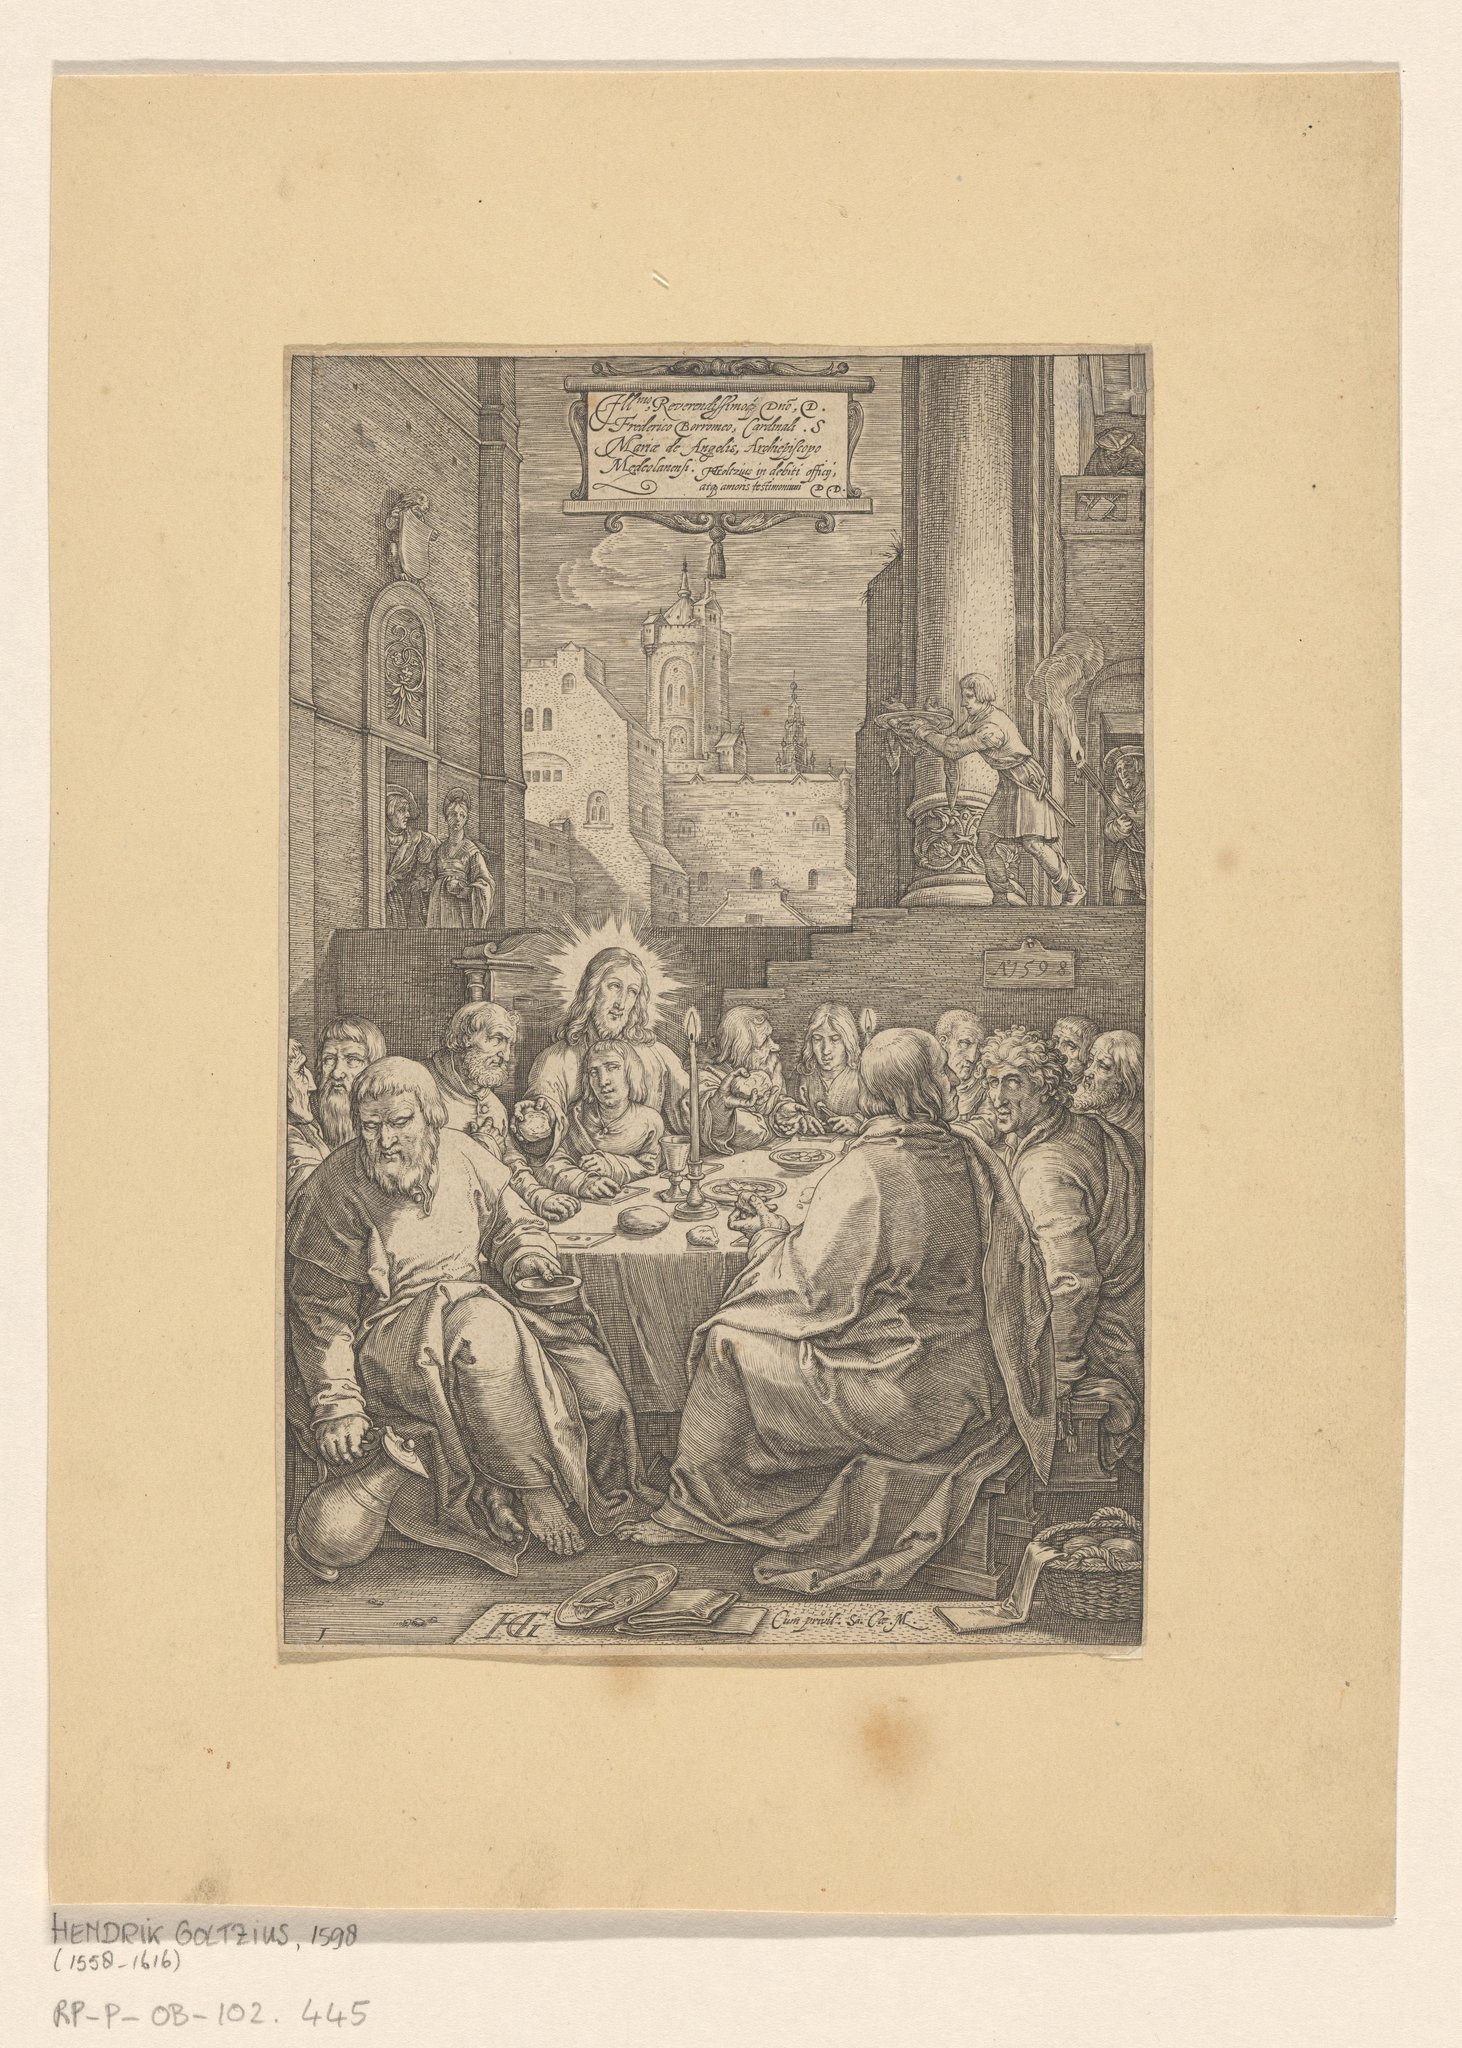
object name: print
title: Het Laatste Avondmaal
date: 1598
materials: paper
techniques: engraving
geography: haarlem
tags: last supper (in general) (matthew 26:21-35; mark 14:18-31; luke 22:3, 22:15-23; john 13:21-38)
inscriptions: collector's mark: Lugt 2228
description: De twaalf bladen van deze serie zijn gegraveerd in de stijl van Lucas van Leyden, maar ook komen delen van de composities overeen met gedeeltes van Dürers Passie. Er bevindt zich een ongedateerde tekening die gediend heeft als model voor de prent in het Museum für Bildende Kunst in Leipzig (afgebeeld in Reznicek, zie literatuur). Jacobs, G.